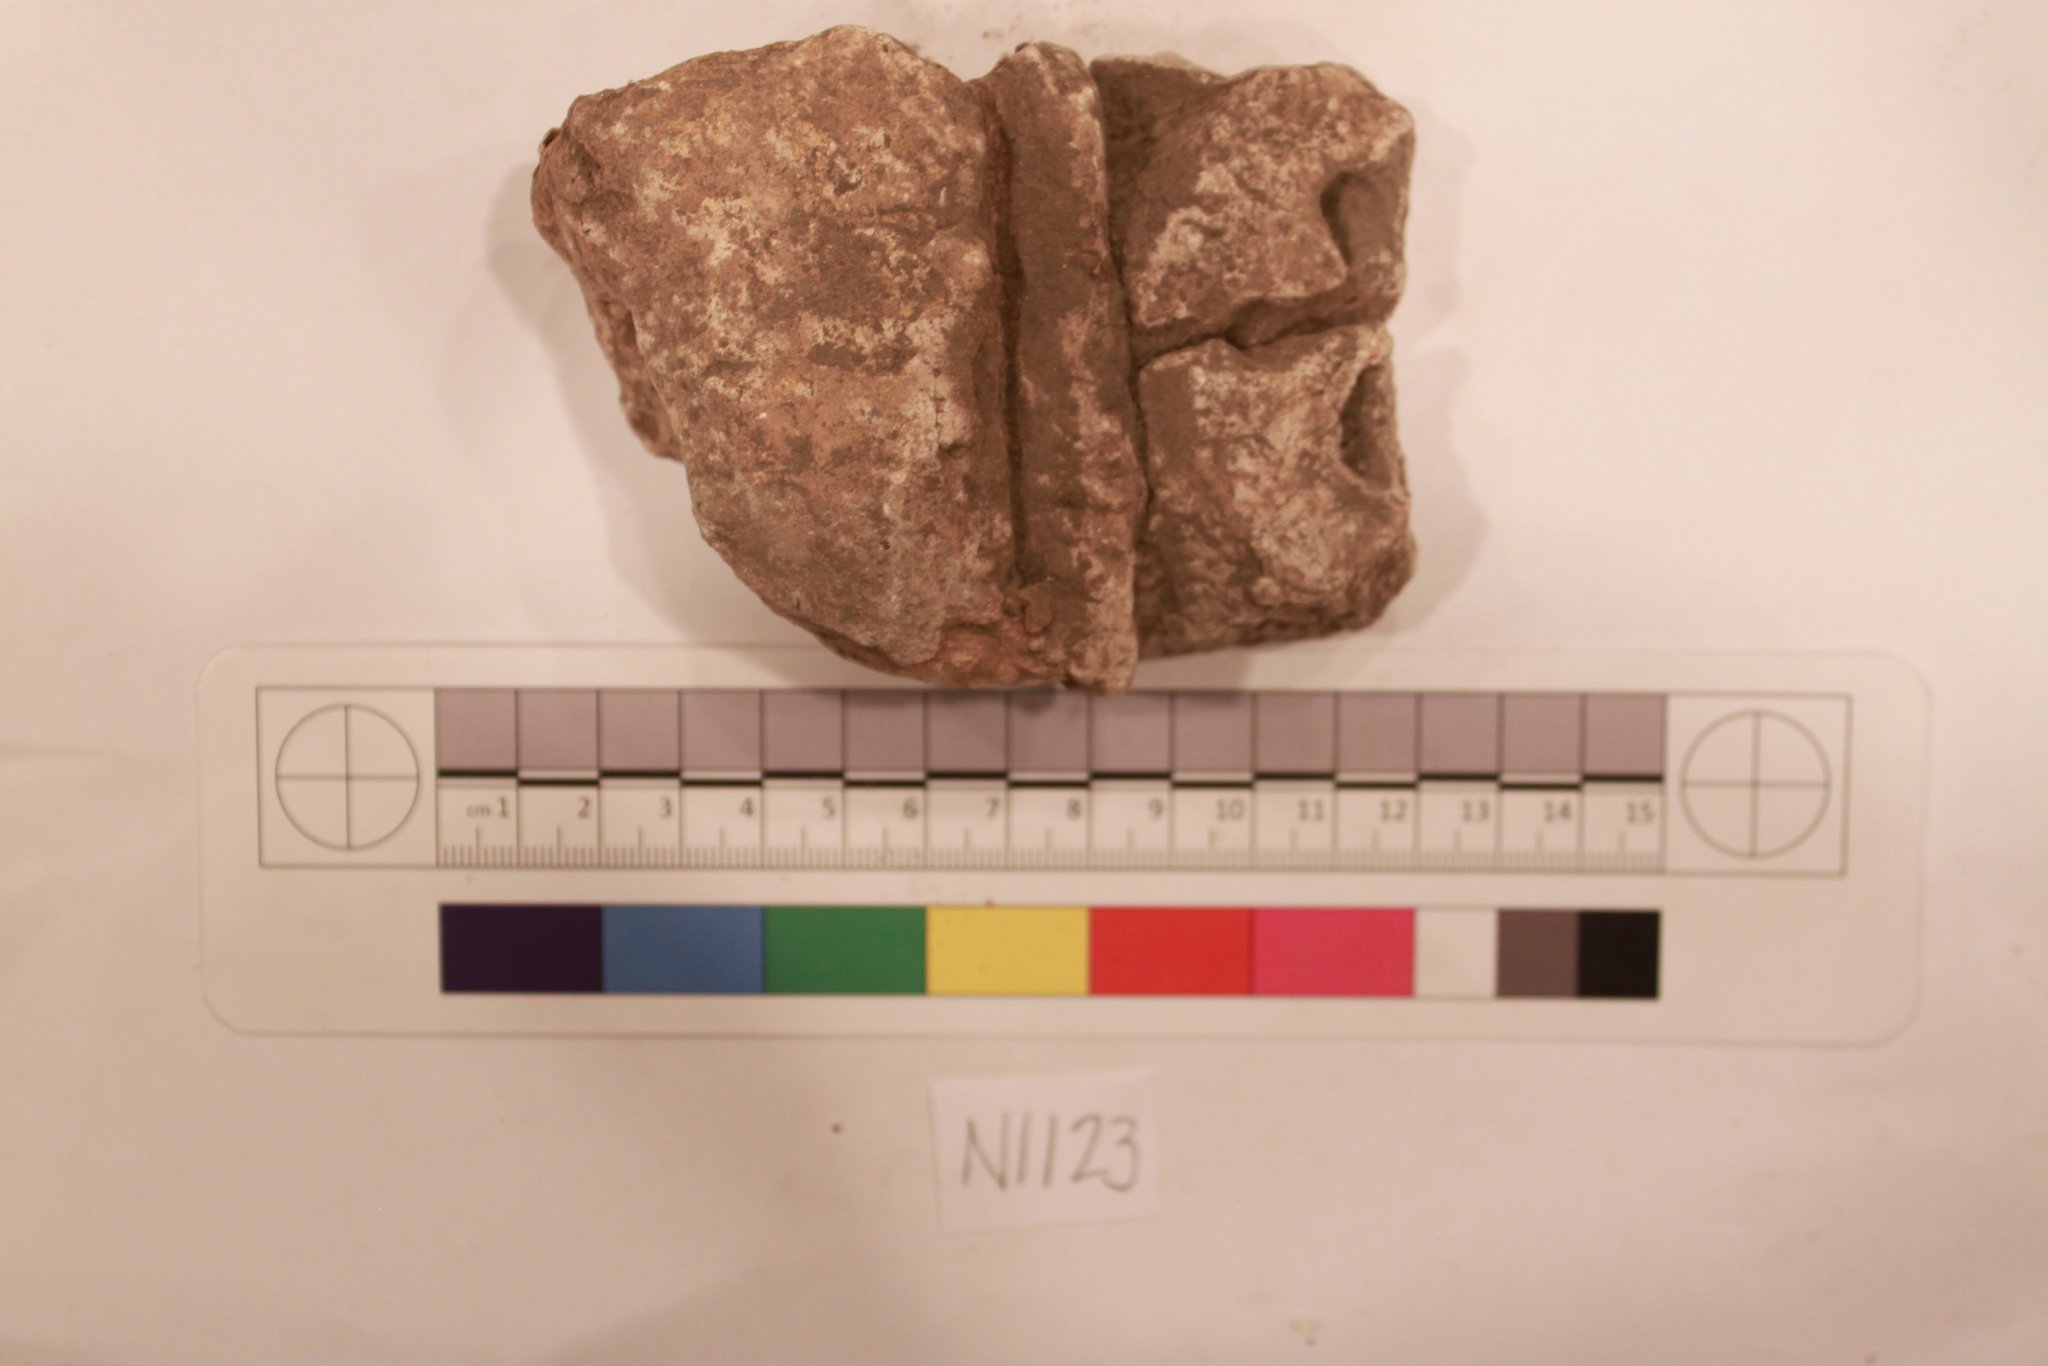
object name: fragment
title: Stucco Fragment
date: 701-1200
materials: plaster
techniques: carving, painting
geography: iran